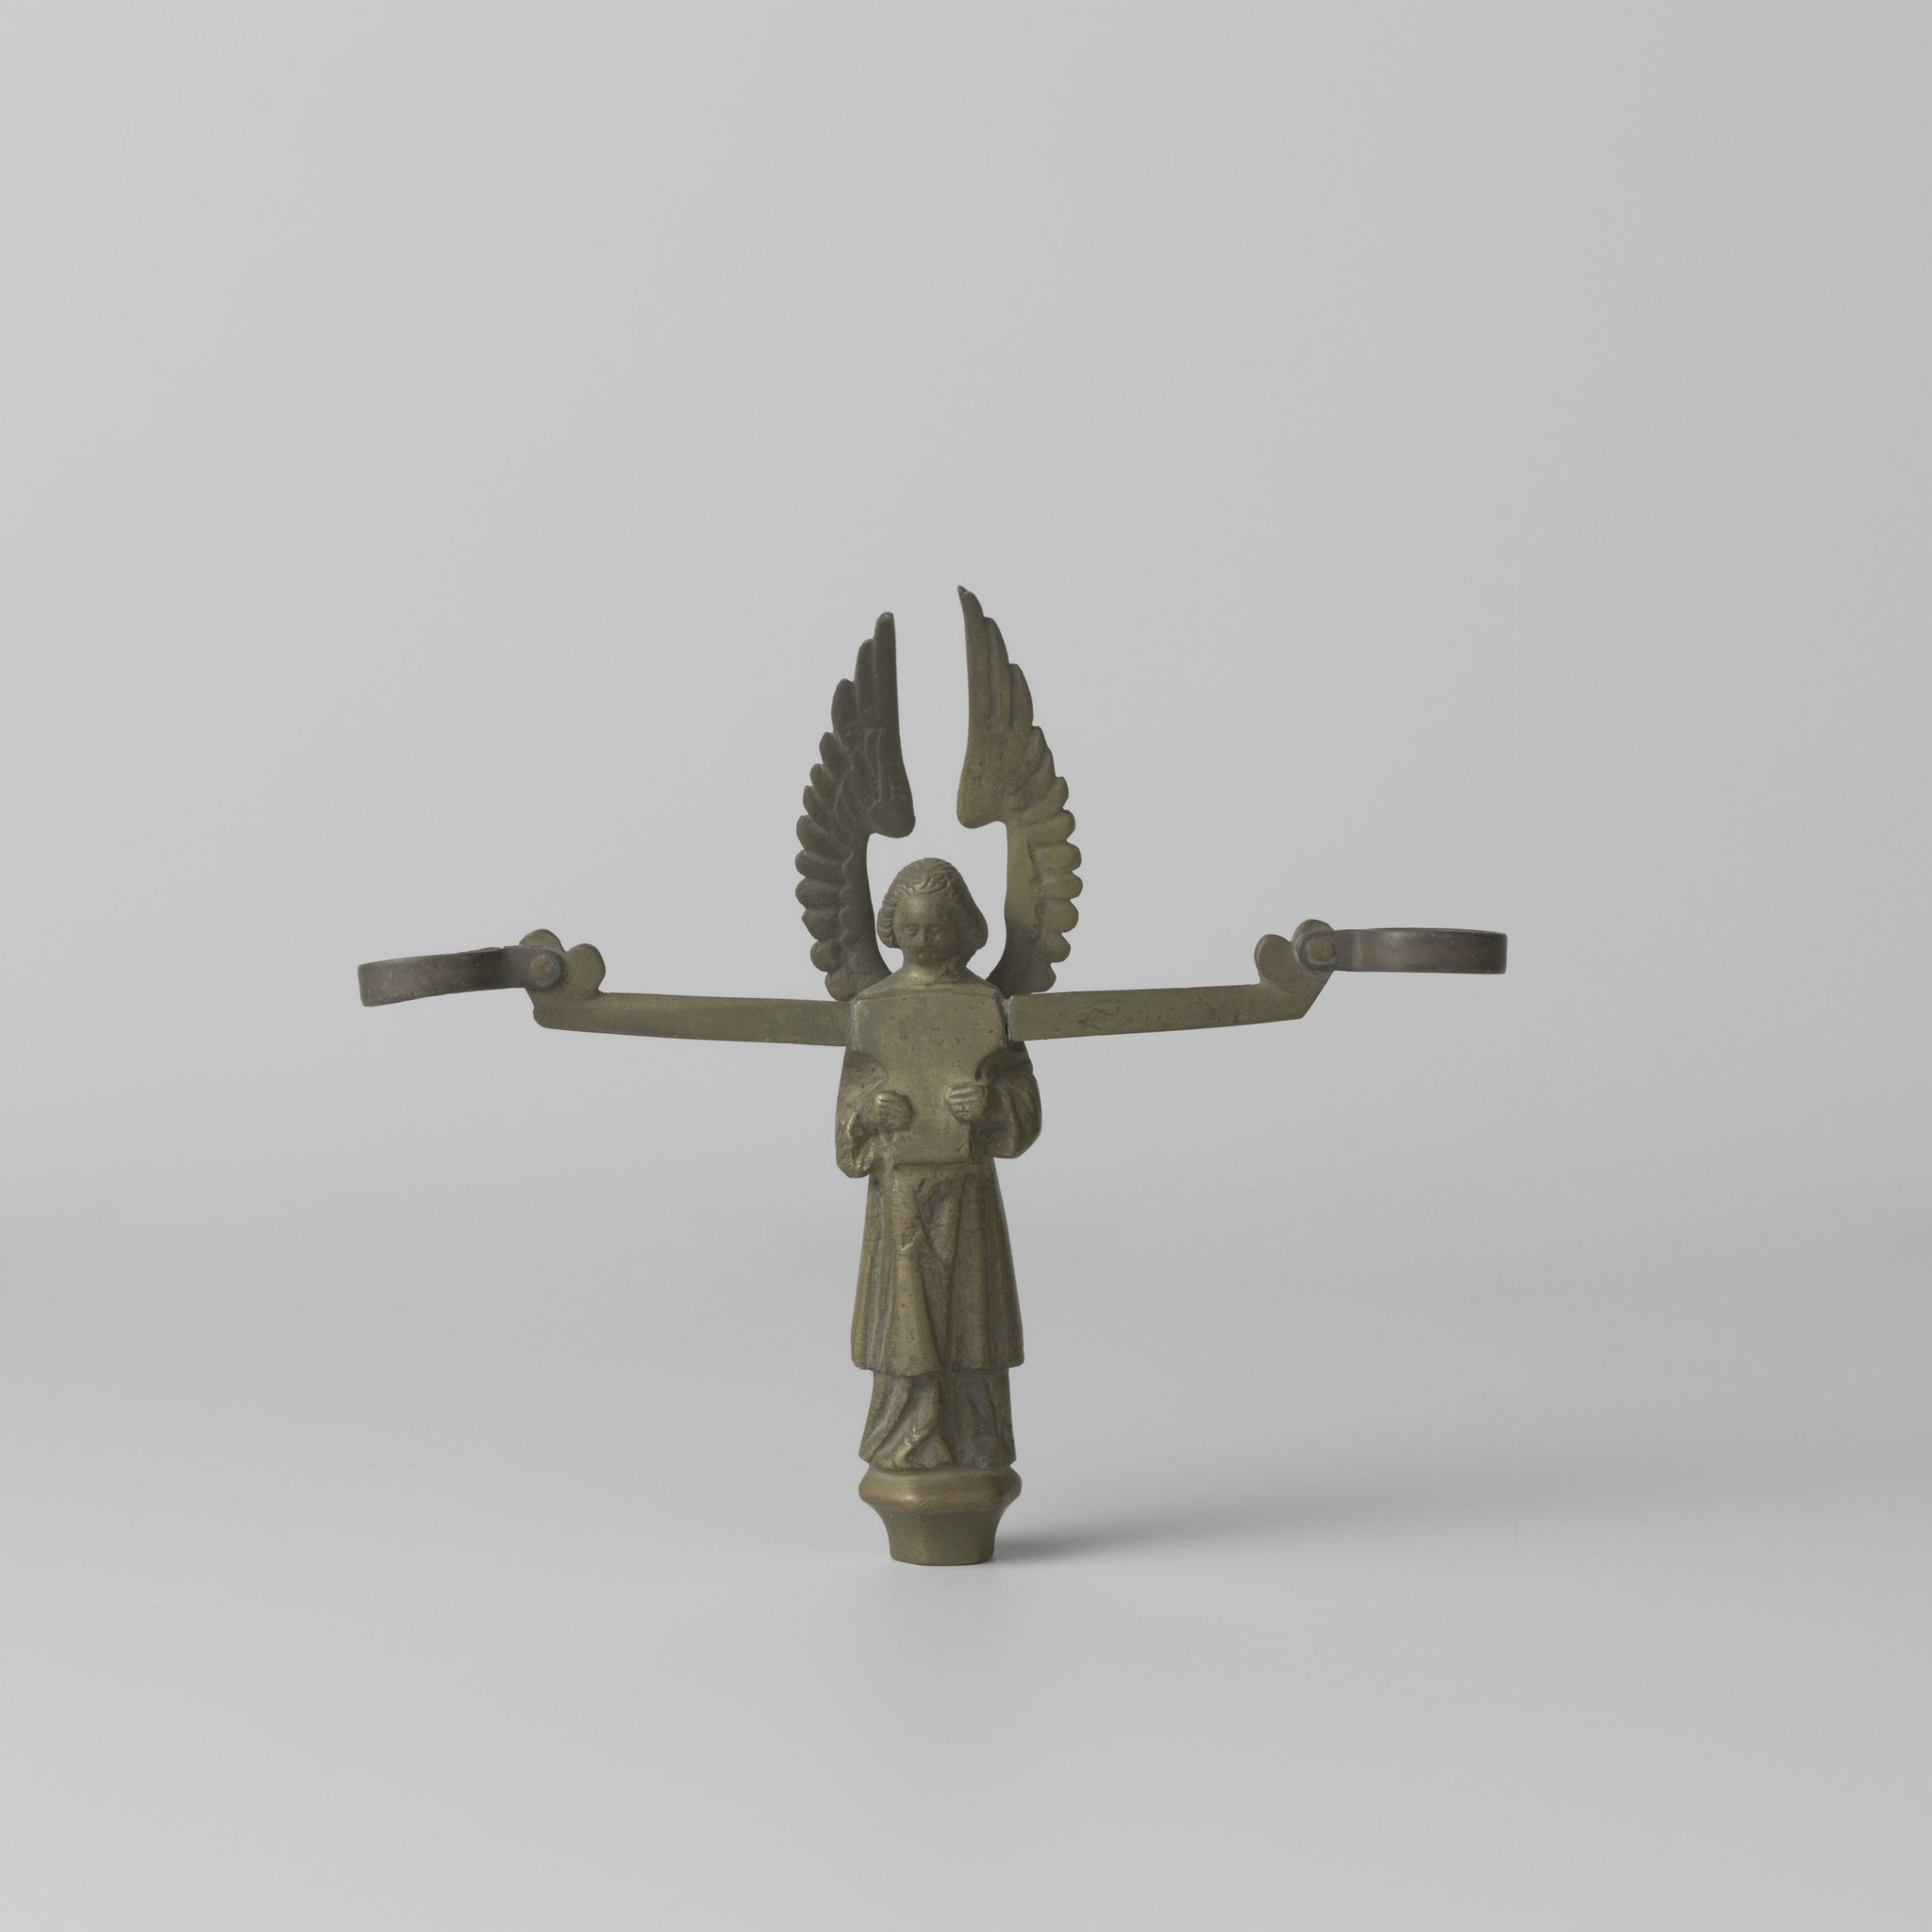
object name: candlestick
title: Engel, toevoeging bij kandelaar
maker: Anonymous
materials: brass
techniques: casting, screwed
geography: southern netherlands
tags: angels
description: Dit voorwerp is een toevoeging bij de kandelaar (BK-NM-2381). De engel houdt met beide handen een verbindingselement vast, waar aan de einden twee ogen zijn gemonteerd, waardoor de kaarsen gestoken kunnen worden.